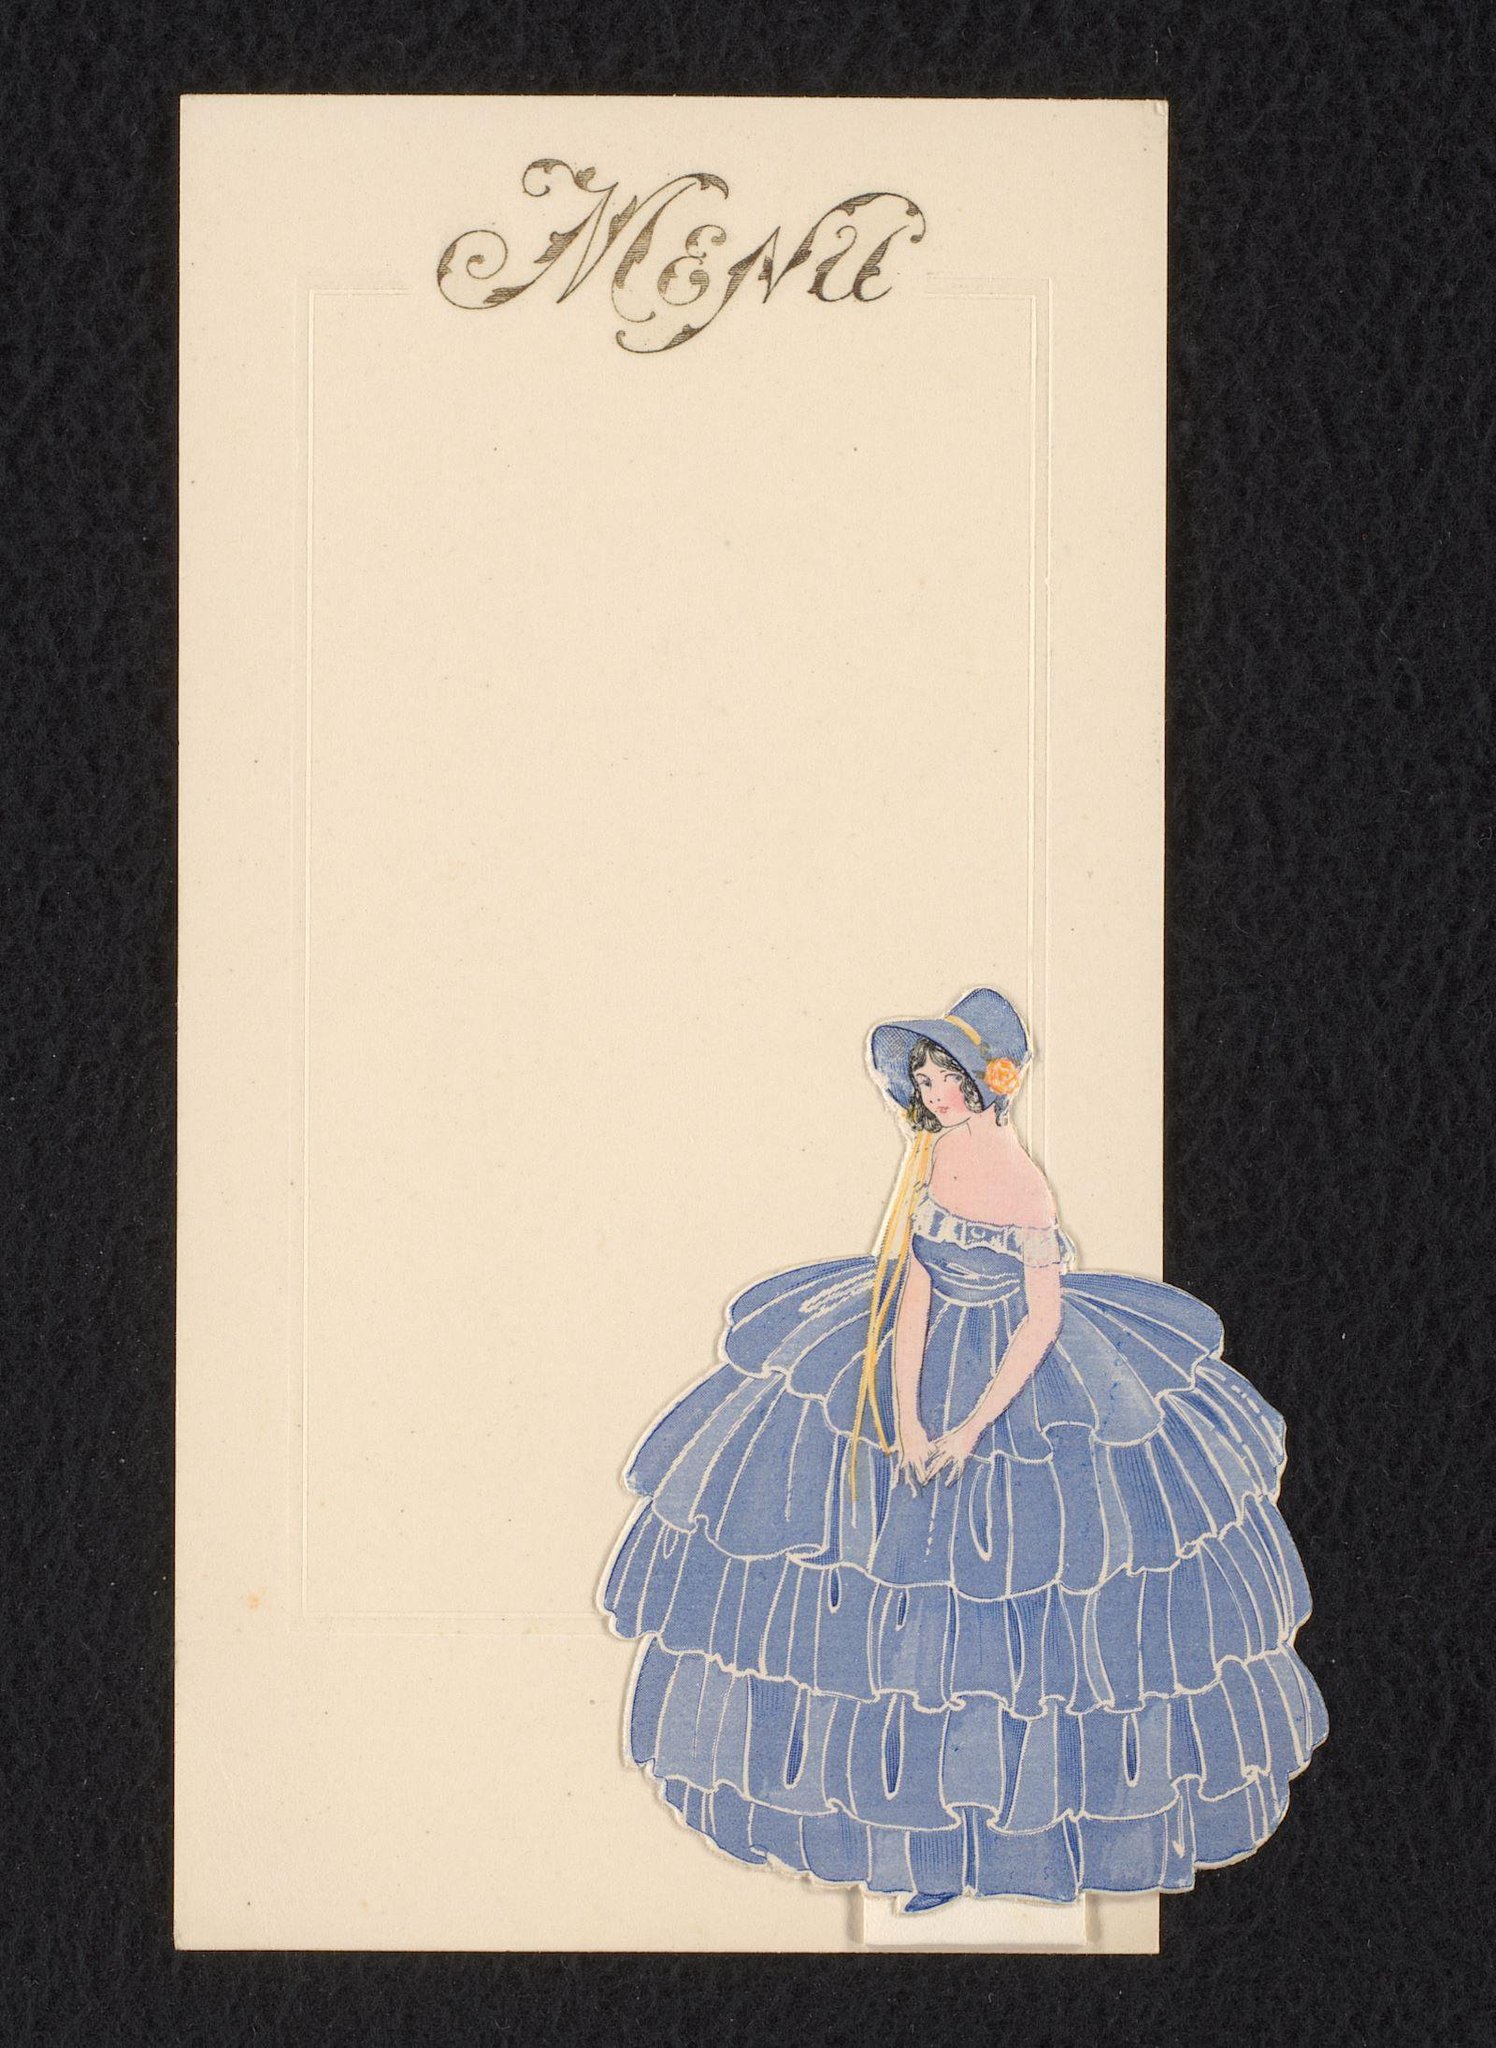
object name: menu, menukaart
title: Menukaart met daarop een vrouw in een jurk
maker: Anonymous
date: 1920-1950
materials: paper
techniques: blind stamped, printing block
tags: dress, gown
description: Bij gebrek aan gegevens over de vervaardiger is voor de bepaling van de rechten van dit object gebruik gemaakt van de (geschatte) vervaardigingsdatum.